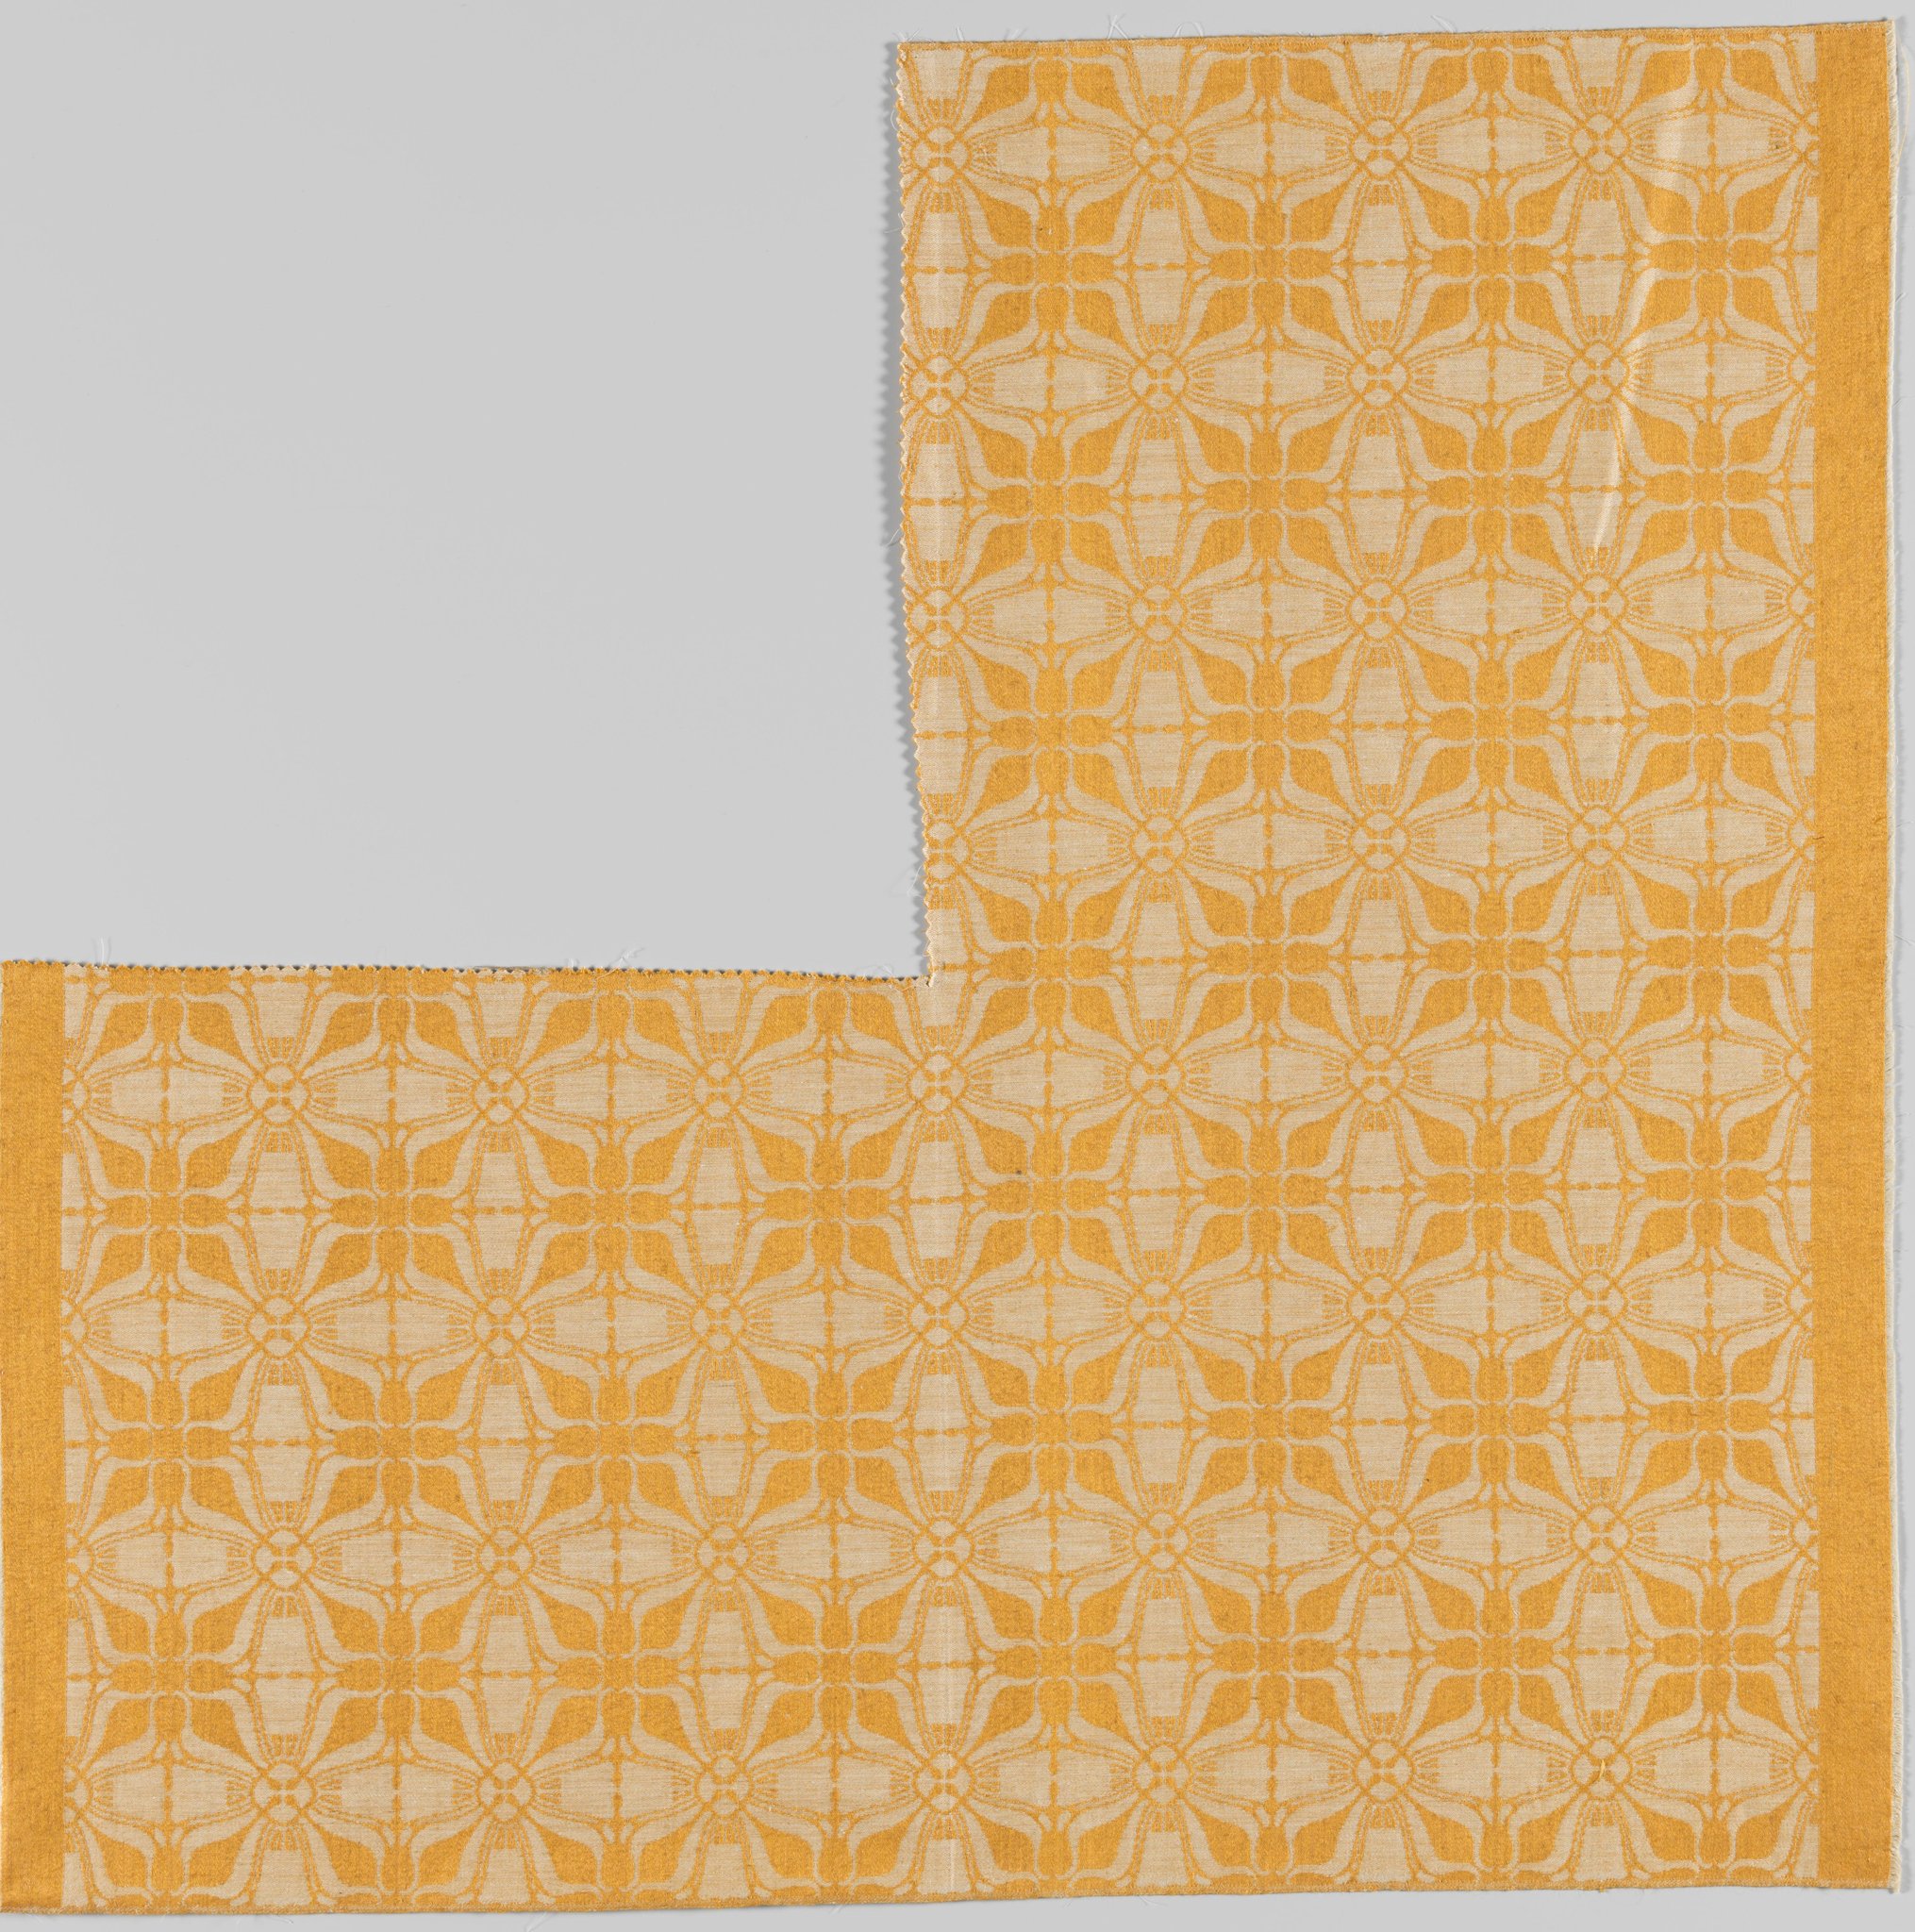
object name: upholstery fabric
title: Staal bespanningsstof van linnendamast met floraal motief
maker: chris lebeau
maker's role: draughtsman, print maker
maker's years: 1878-1945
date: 1911-1915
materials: linen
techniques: damask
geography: eindhoven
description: Staal bespanningsstof van linnendamast met gestileerd bloemmotief in naturel op een goudgele fond.